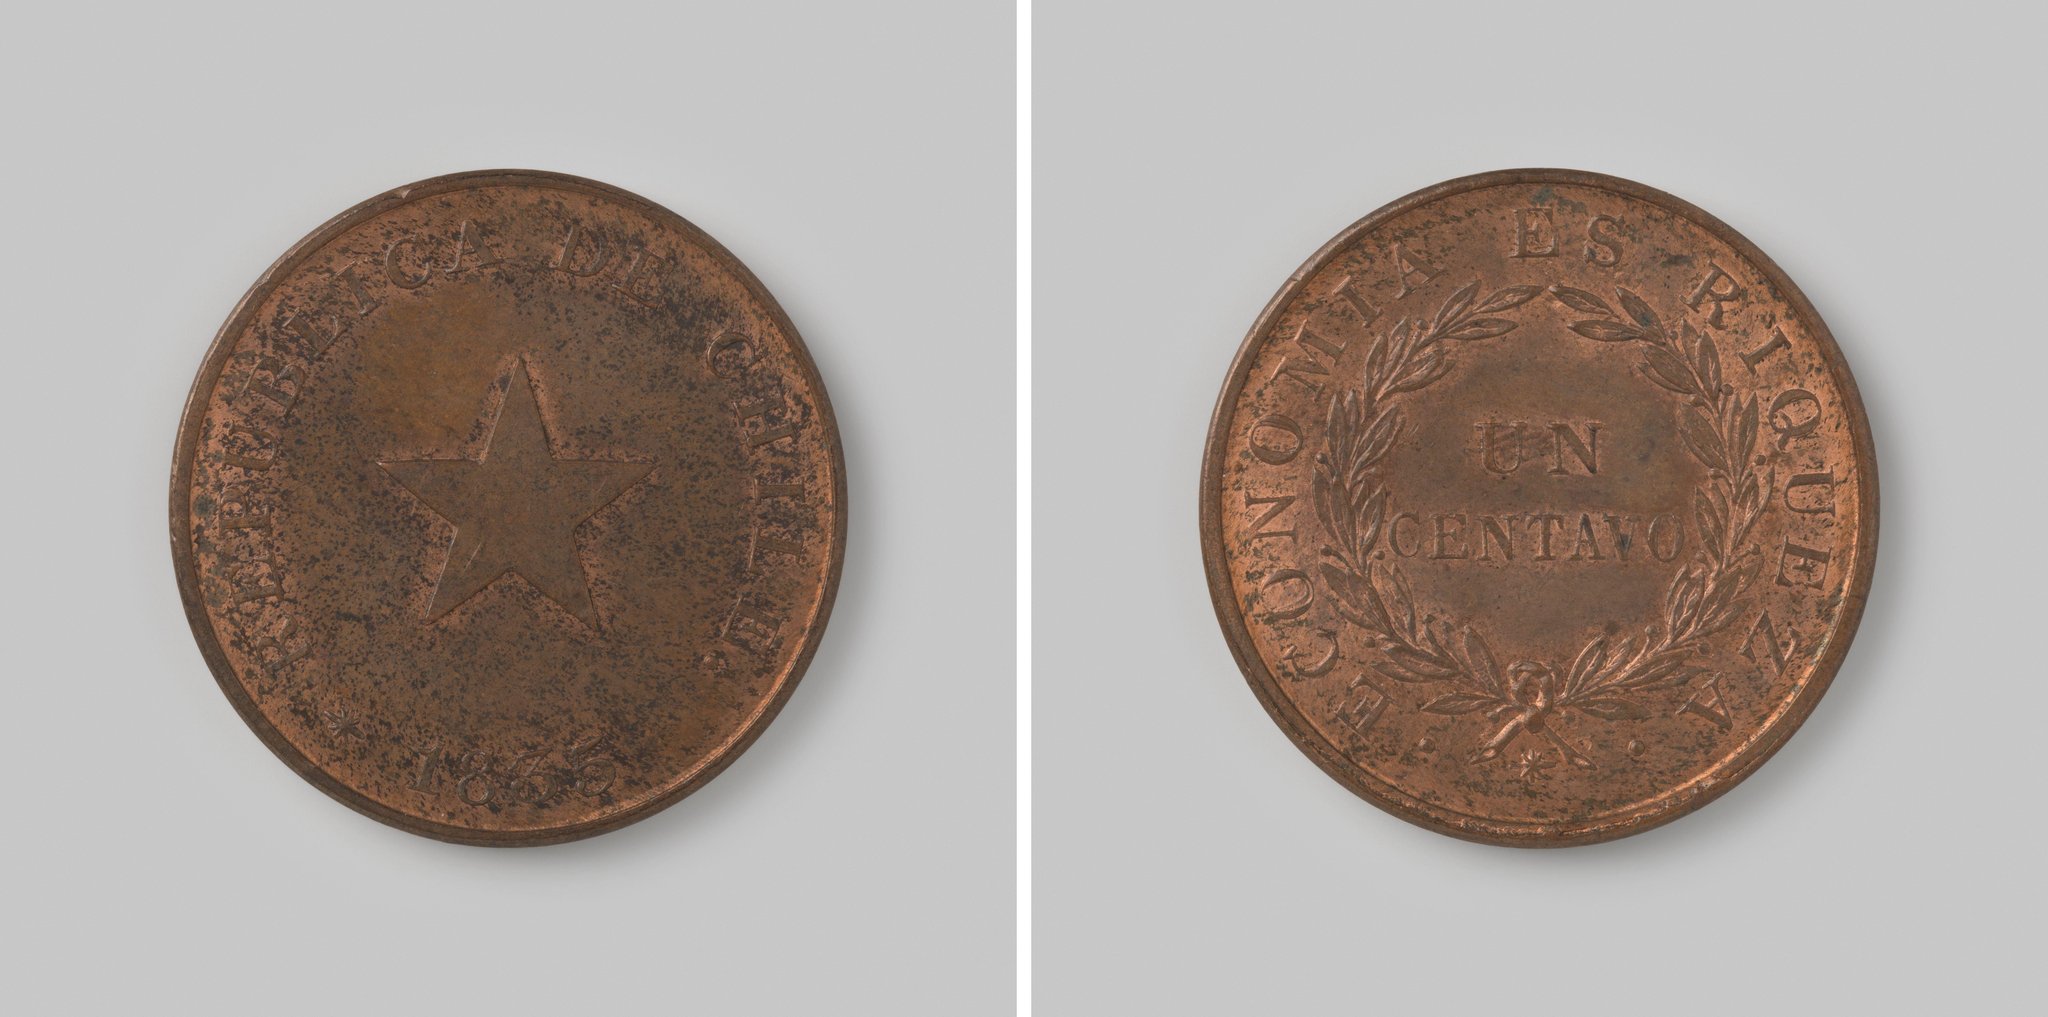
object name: coin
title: Chili, centavo, 1853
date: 1853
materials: copper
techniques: striking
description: Koperen munt. Voorzijde: vijfpuntige ster. Jaartal onderaan. Keerzijde: tussen twee samengebonden takken in twee regels waarde-aanduiding: un centavo. Gladde rand.